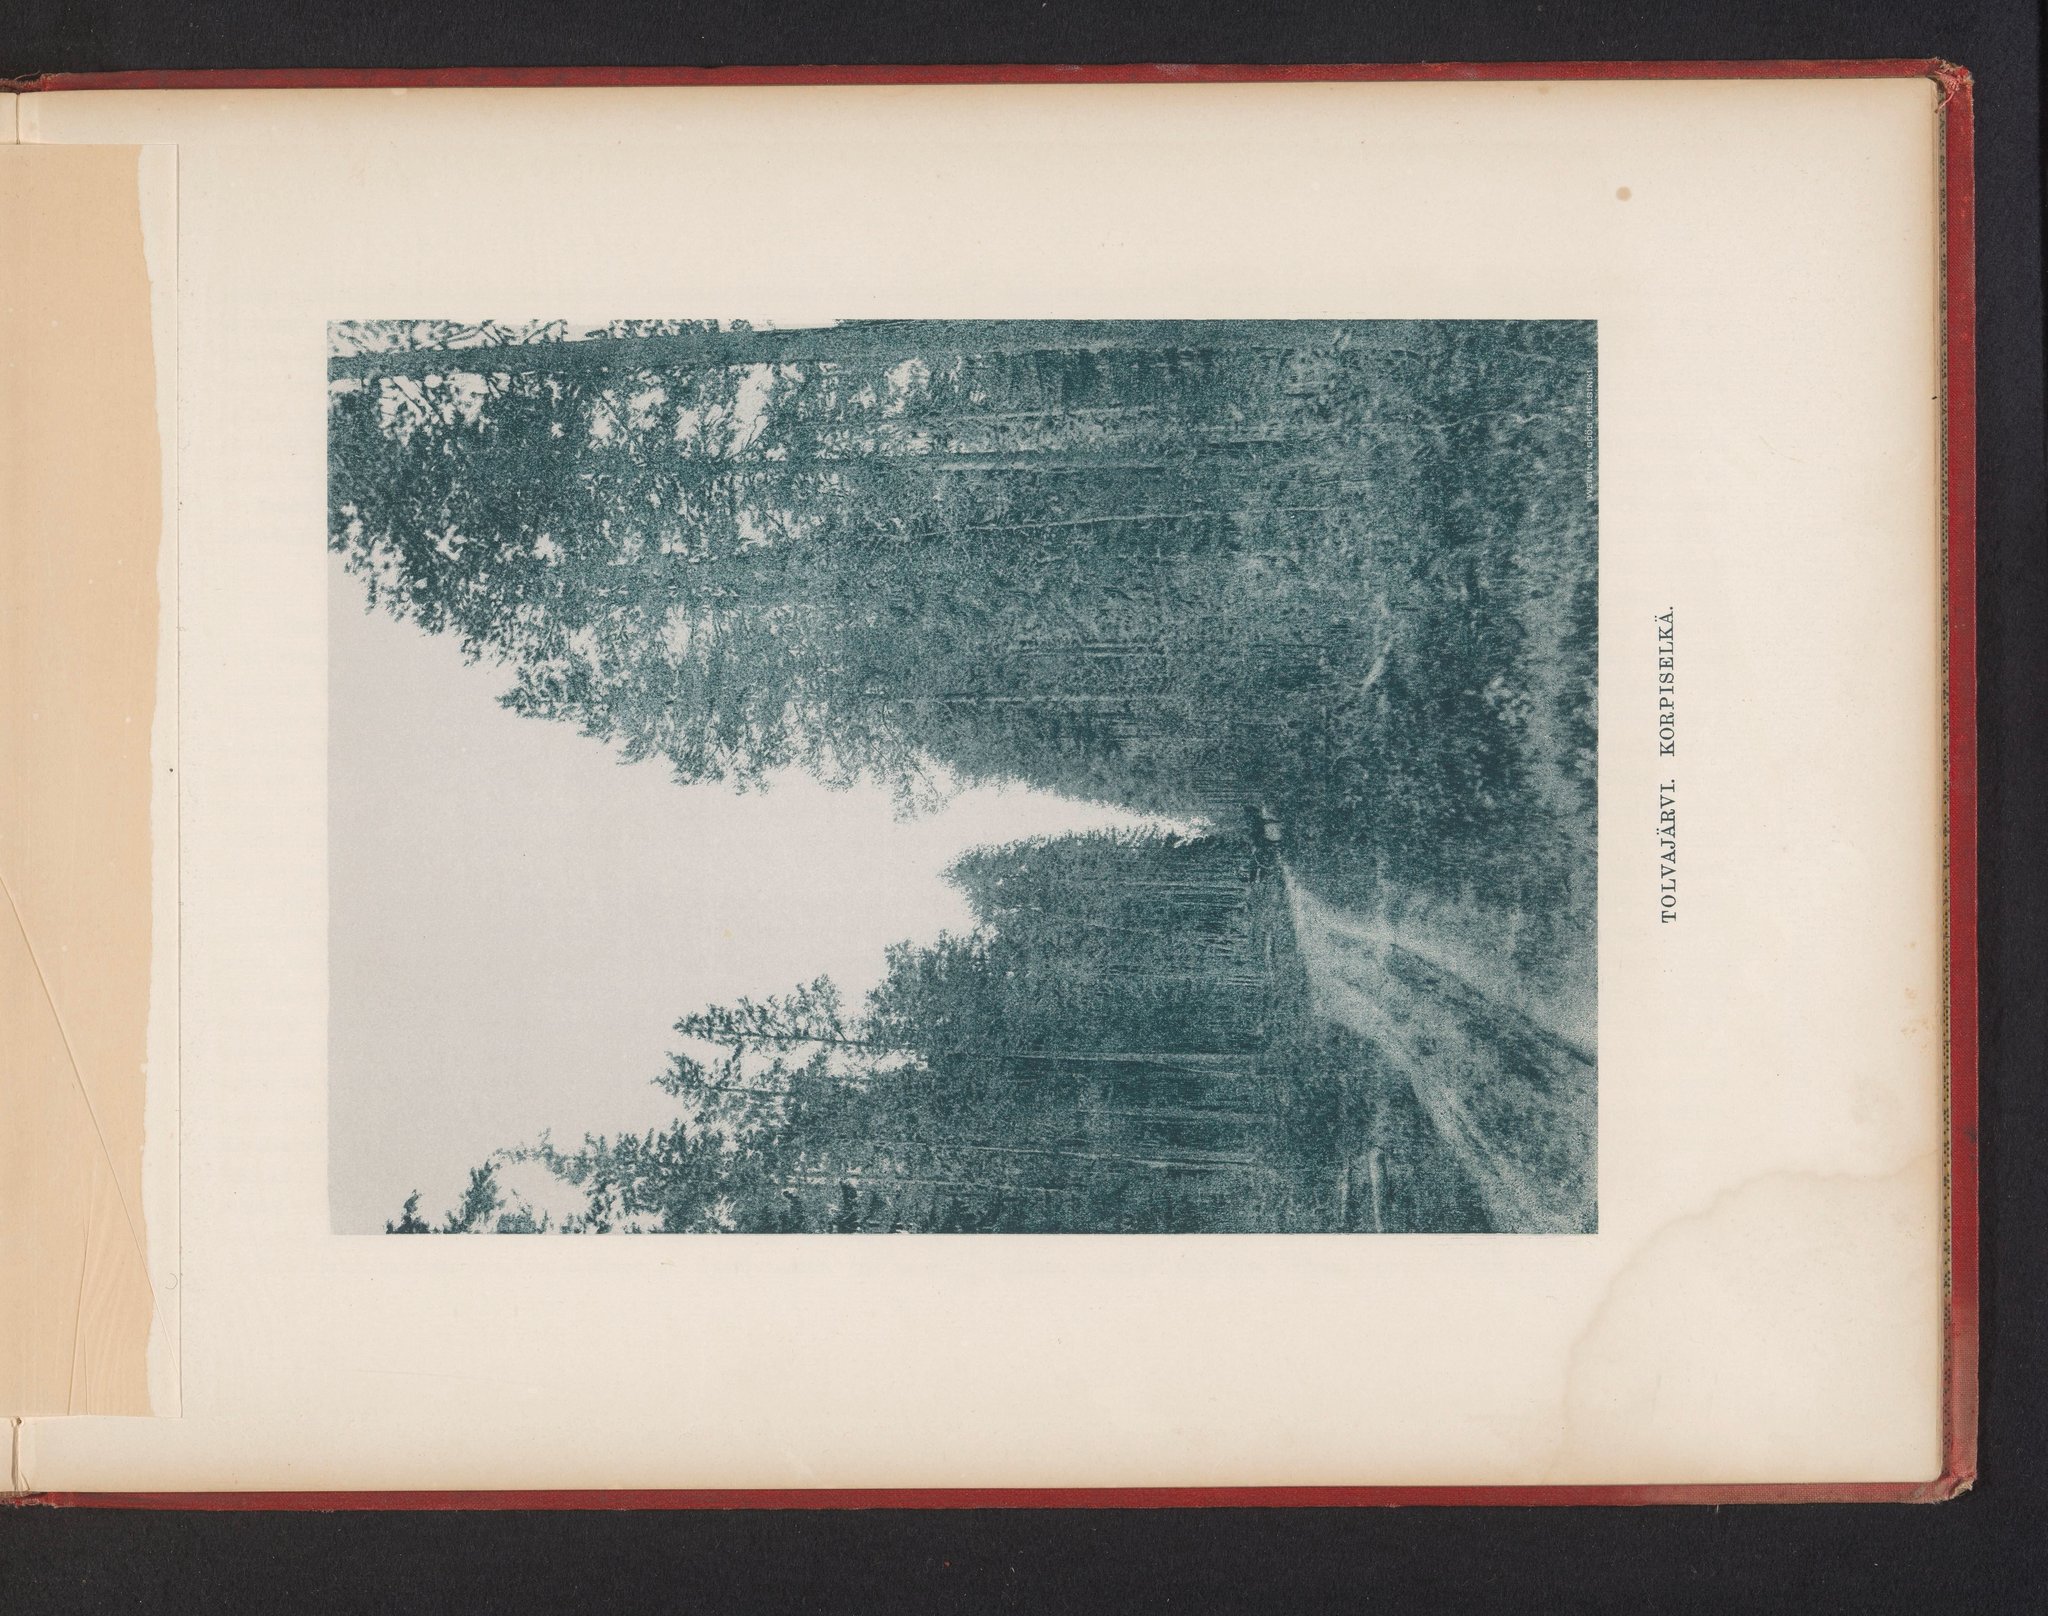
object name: page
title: Gezicht op een pad door een bos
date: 1888-1893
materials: paper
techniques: autotype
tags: trees, road, path